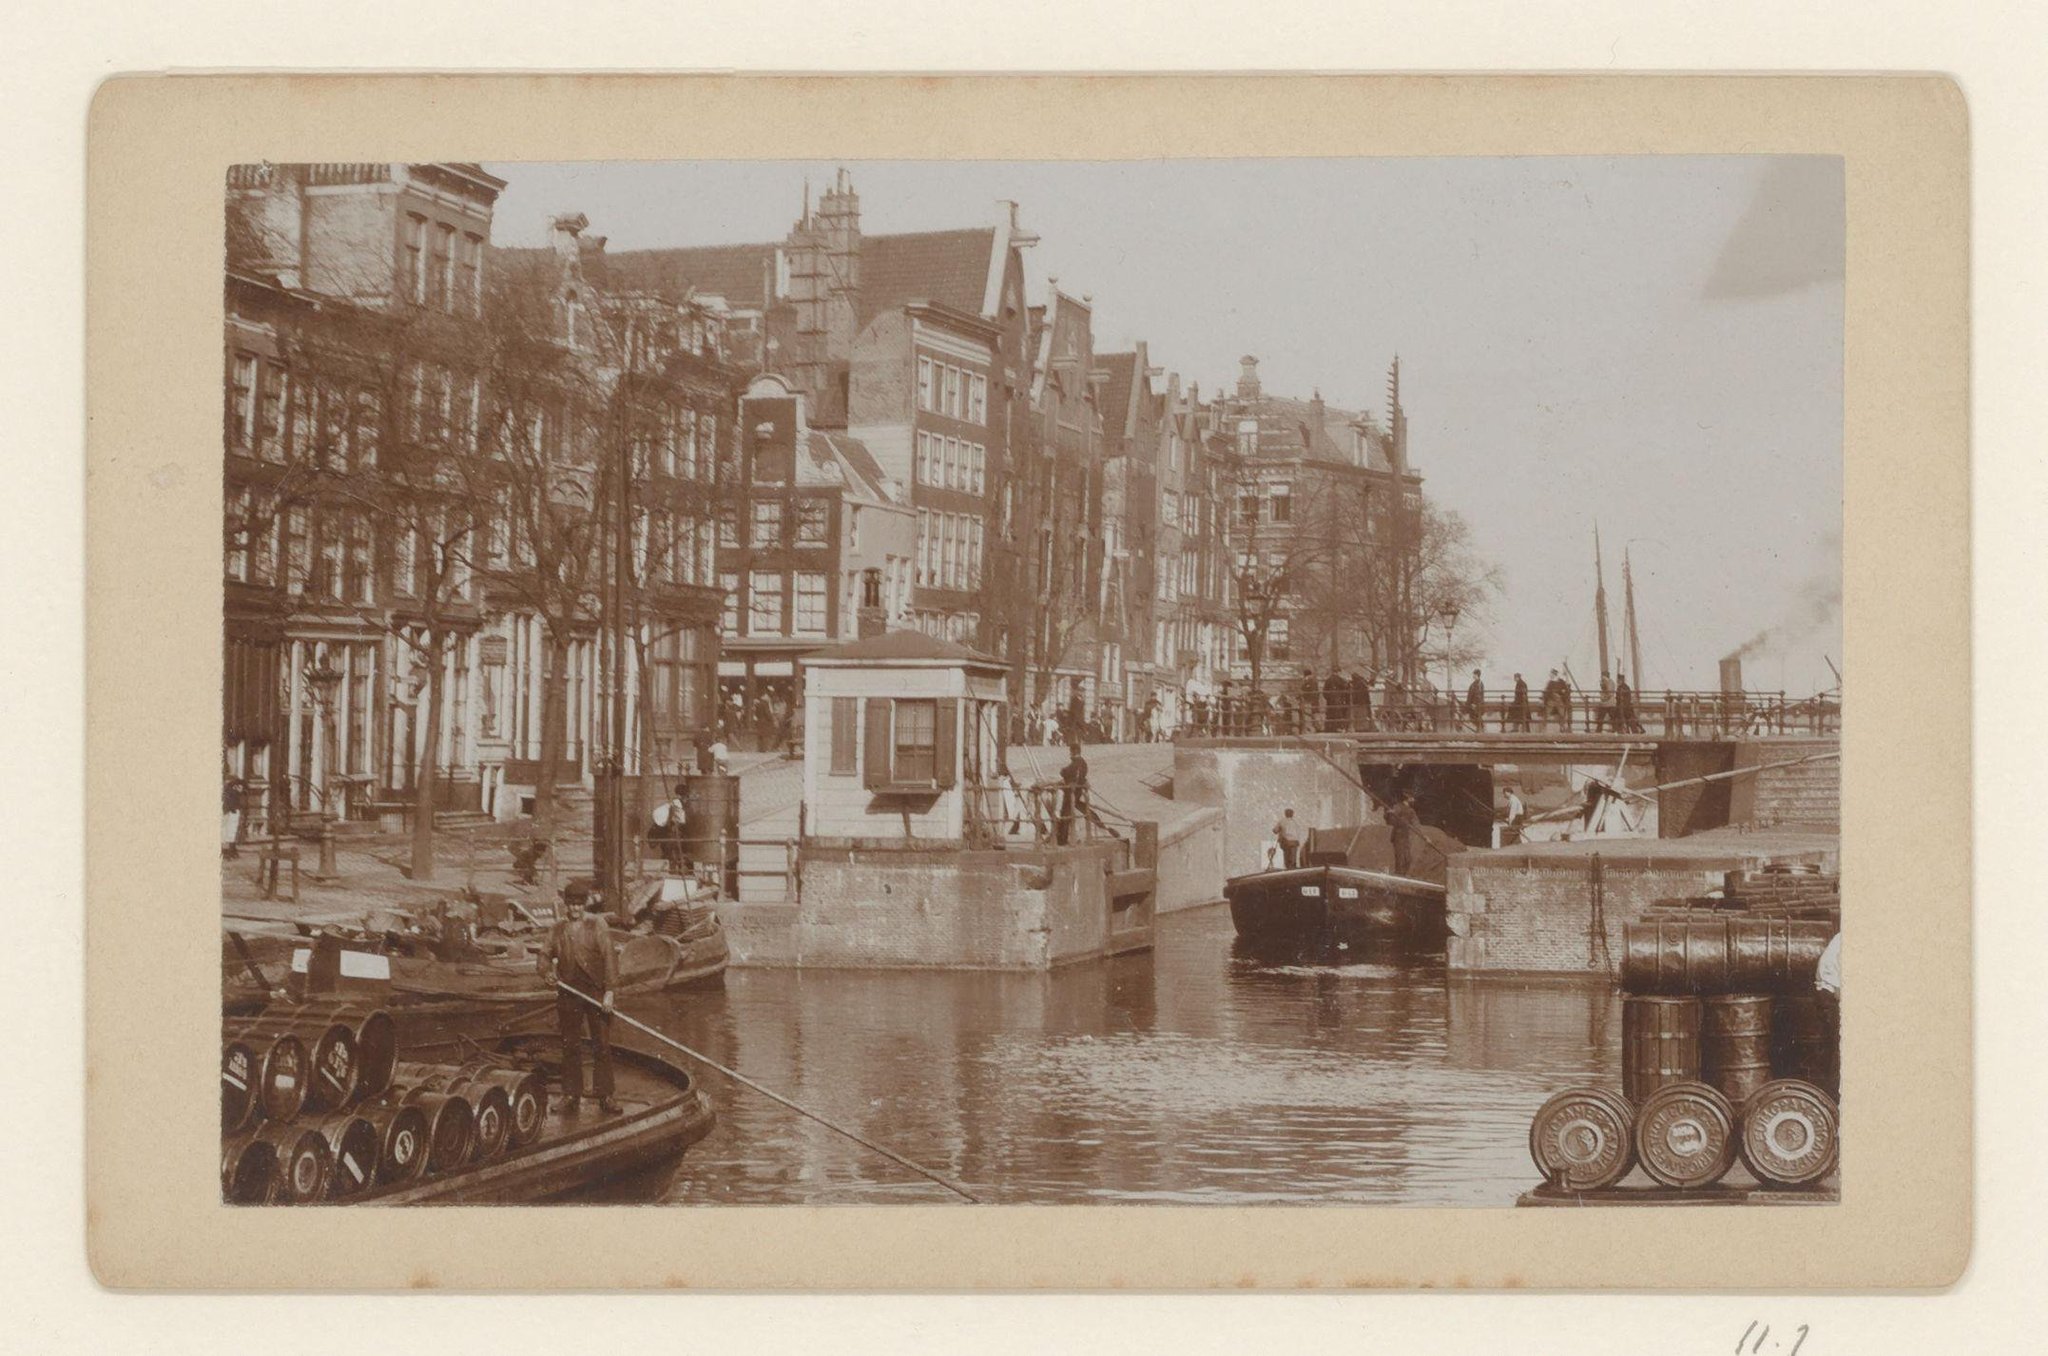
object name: cabinet photograph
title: Gezicht op de Korte Prinsengracht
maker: Anonymous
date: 1865-1940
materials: paper, cardboard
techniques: collodion silver print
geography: amsterdam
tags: city-view in general; 'veduta', canal, the usual house or row of houses, bridge in city across river, canal, etc., street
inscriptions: collector's mark: ‘11.1’ Lugt 1641b, inscription: ‘no 48 Korte Prinsengr’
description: Onderwerpsrubriek binnen de Atlas Amsterdam: Paleisstraat, Palmgracht, Papenbrugsteeg, Passeerdersgracht, Peperstraat, Pieterspoort (St.), Pieterssteeg (St.), Plantage, Prinseneiland.